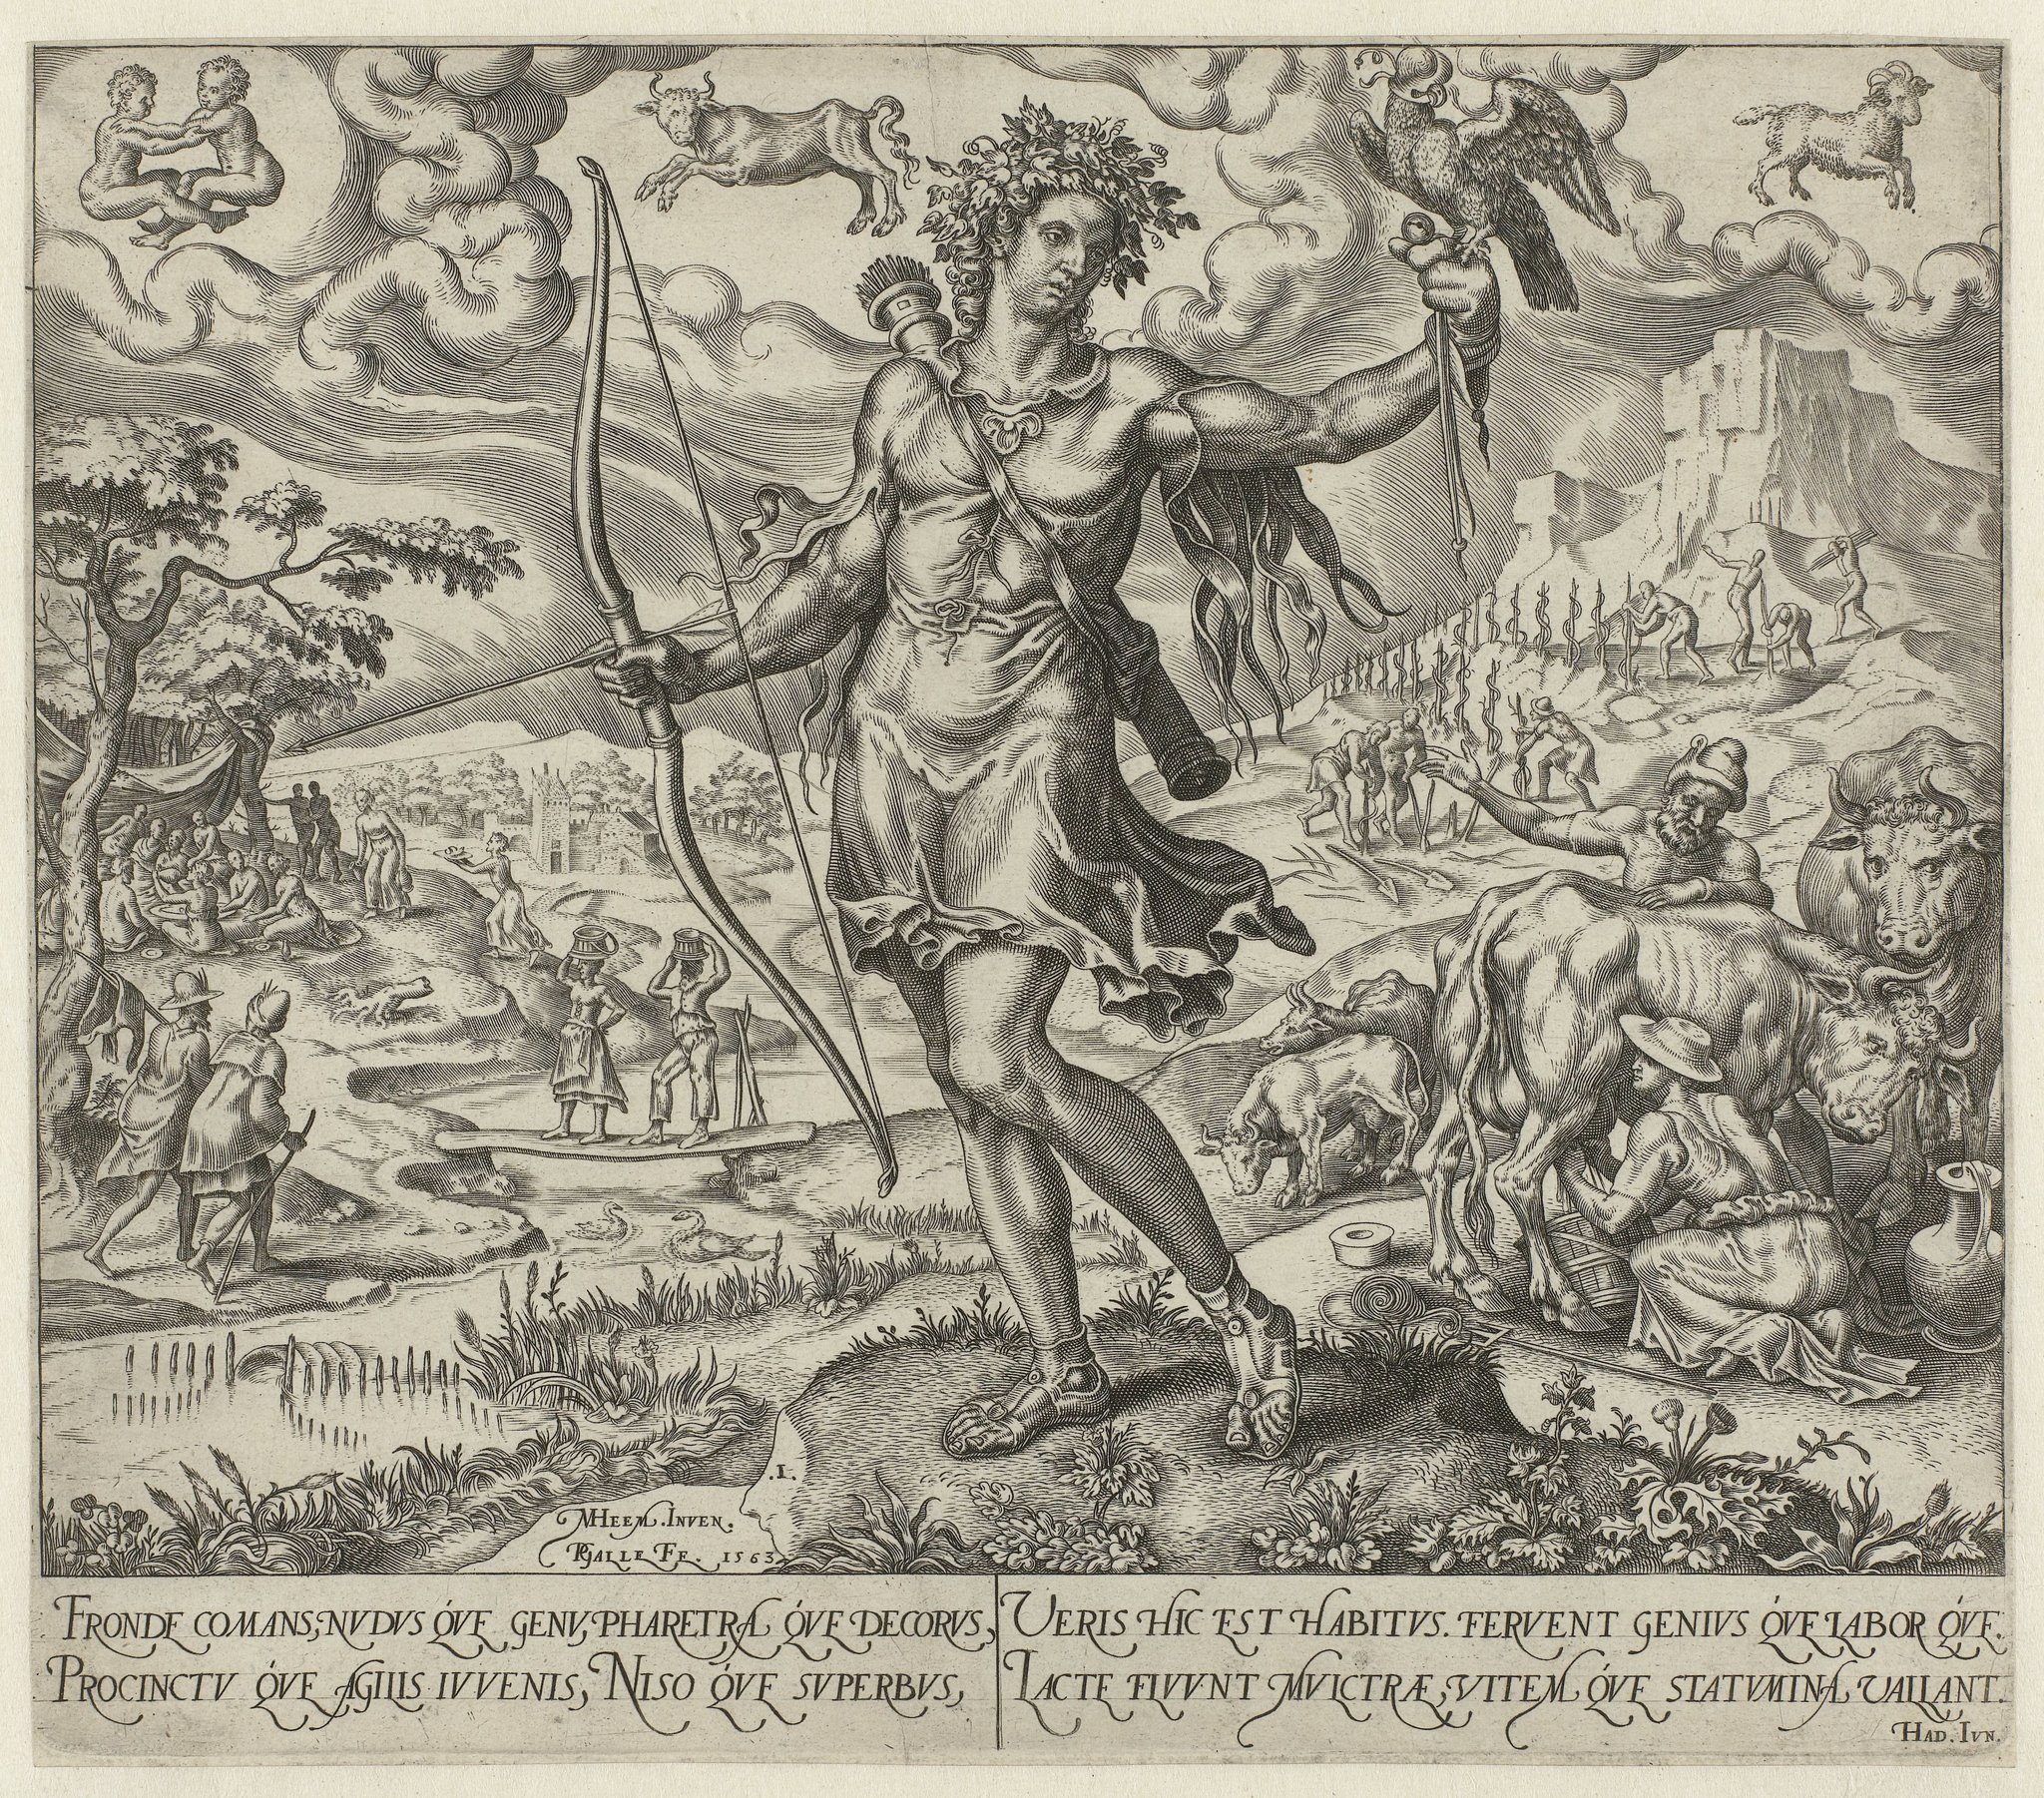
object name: print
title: Lente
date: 1563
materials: paper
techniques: engraving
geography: haarlem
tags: spring, 'ver'; 'primavera' (ripa), spring landscape; landscape symbolizing spring (the four seasons of the year) (+ with scenes showing human occupations ~ seasons and months), spring landscape; landscape symbolizing spring (the four seasons of the year) (+ with zodiacal signs of the spring season)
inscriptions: collector's mark: Lugt 2760, collector's mark: Lugt 2228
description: In de voorgrond de personificatie van de Lente: een jongeling gekroond met een bloemenkrans. In zijn handen een pijl en boog en een valk, attributen van de jacht. Op de achtergrond voorjaarstaferelen: een melkende boerin, tuinbouw en wandelen.Boven in de lucht de drie astrologische tekens van het voorjaar: Ram, Stier en Tweeling. De prent heeft een Latijns onderschrift en is deel van een vierdelige serie over de vier seizoenen.